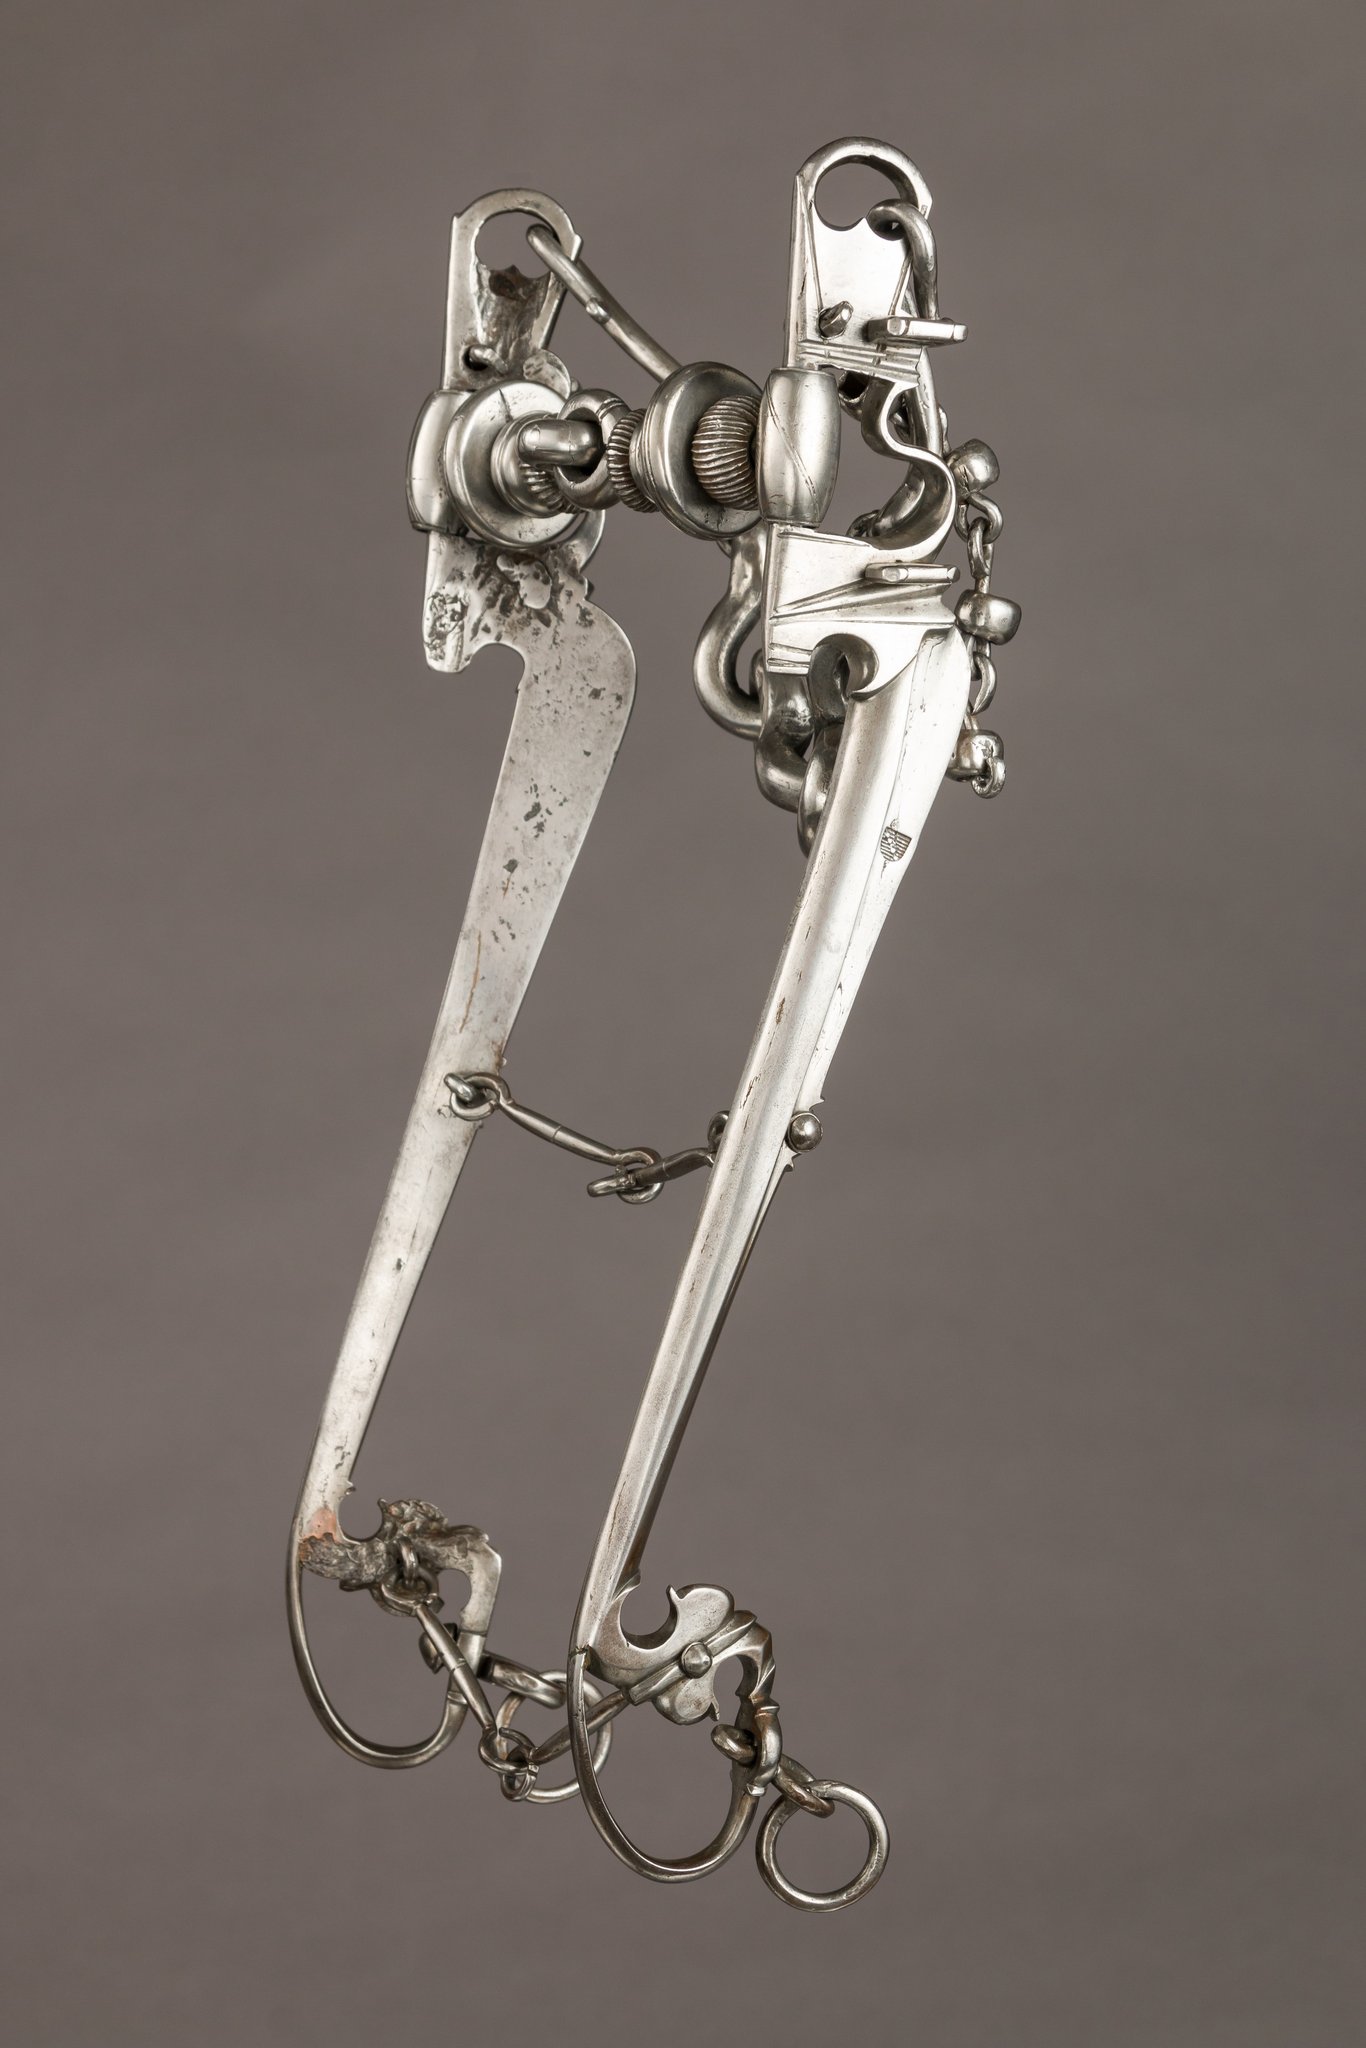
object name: bit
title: Curb Bit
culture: german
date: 1550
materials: metal alloy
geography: germany